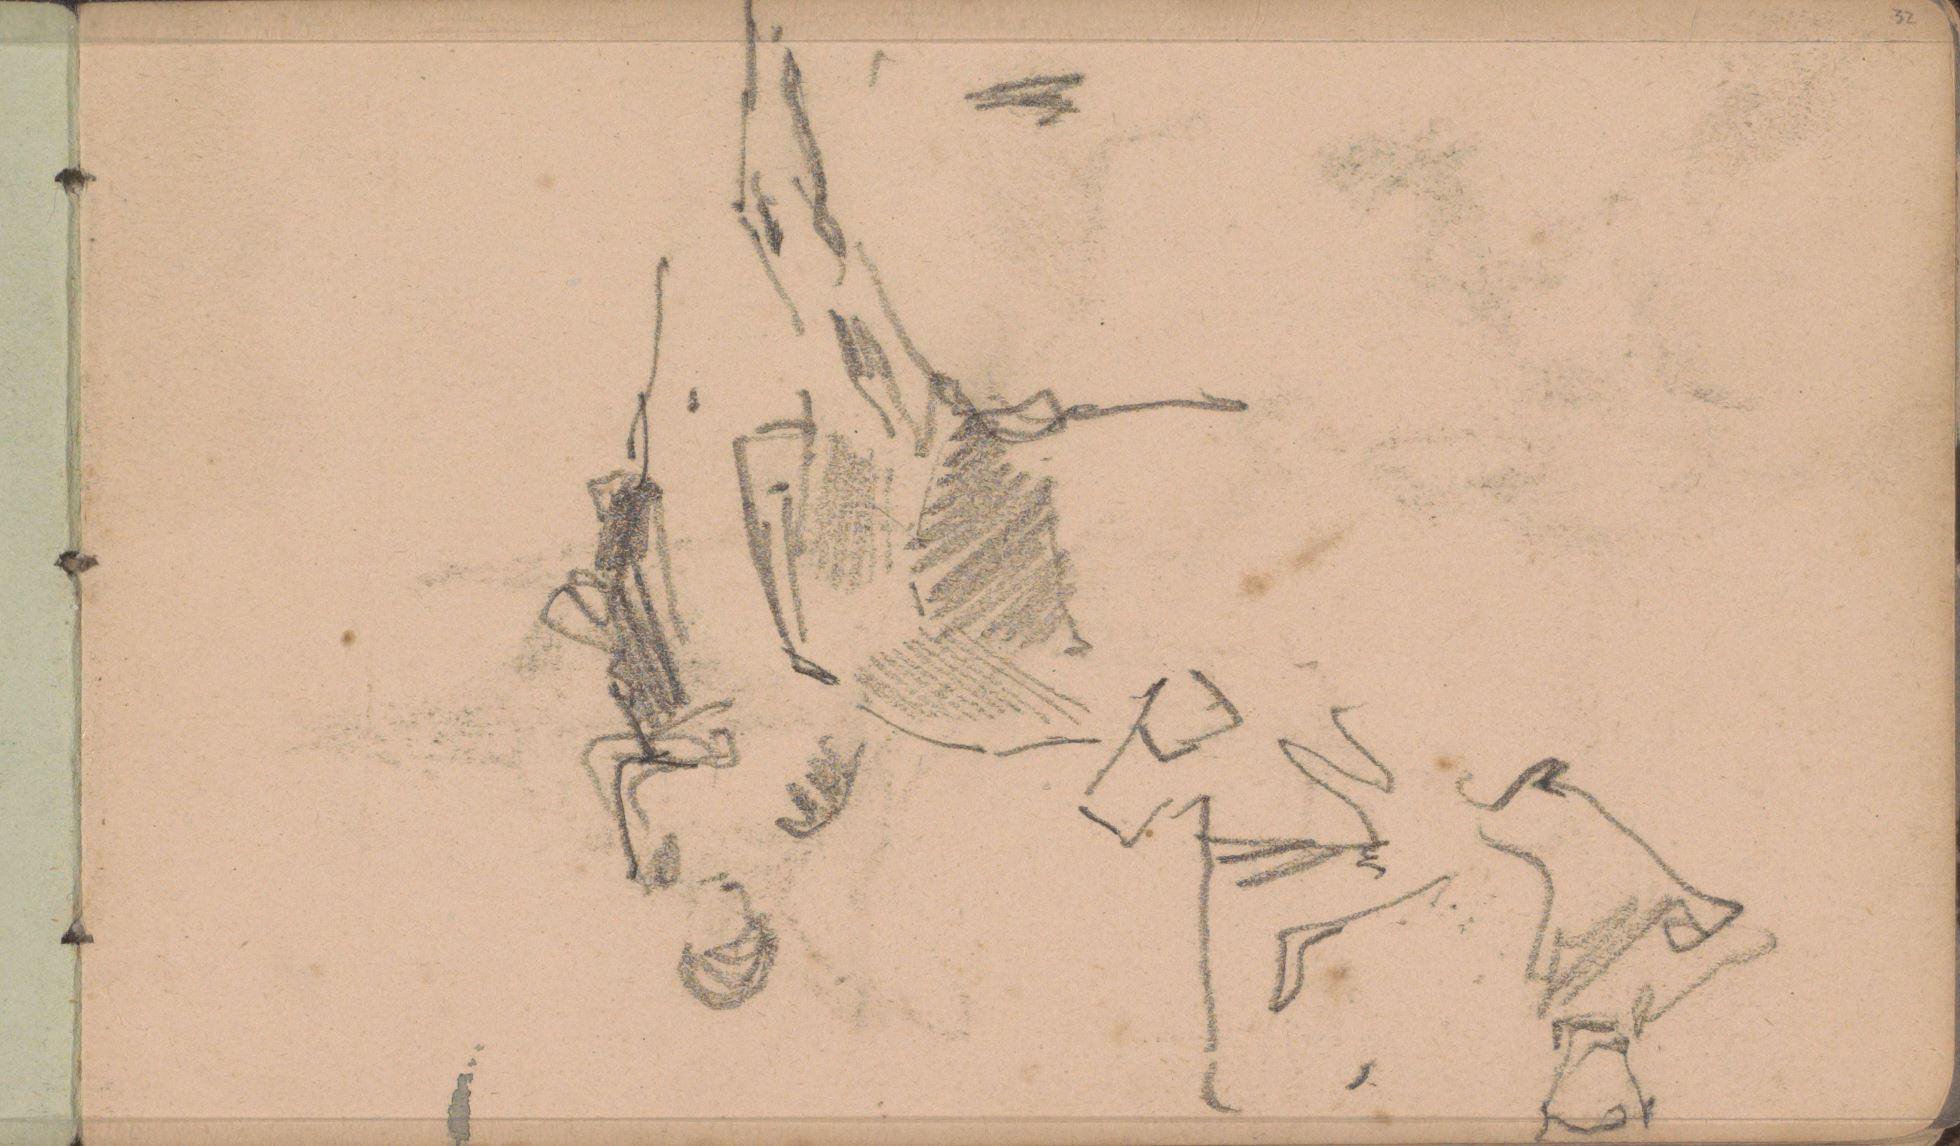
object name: sketchbook leaf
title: Ruiters, mogelijk cavaleristen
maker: george hendrik breitner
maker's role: draughtsman, painter, print maker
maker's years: 1857-1923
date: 1881-1883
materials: paper, pencil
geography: north brabant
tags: riding a horse, ass, or mule; rider, horseman, adult woman, the soldier; the soldier's life (+ cavalry, horsemen)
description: Achter het paard een vrouw. Pagina 32 uit een schetsboek met 42 bladen.